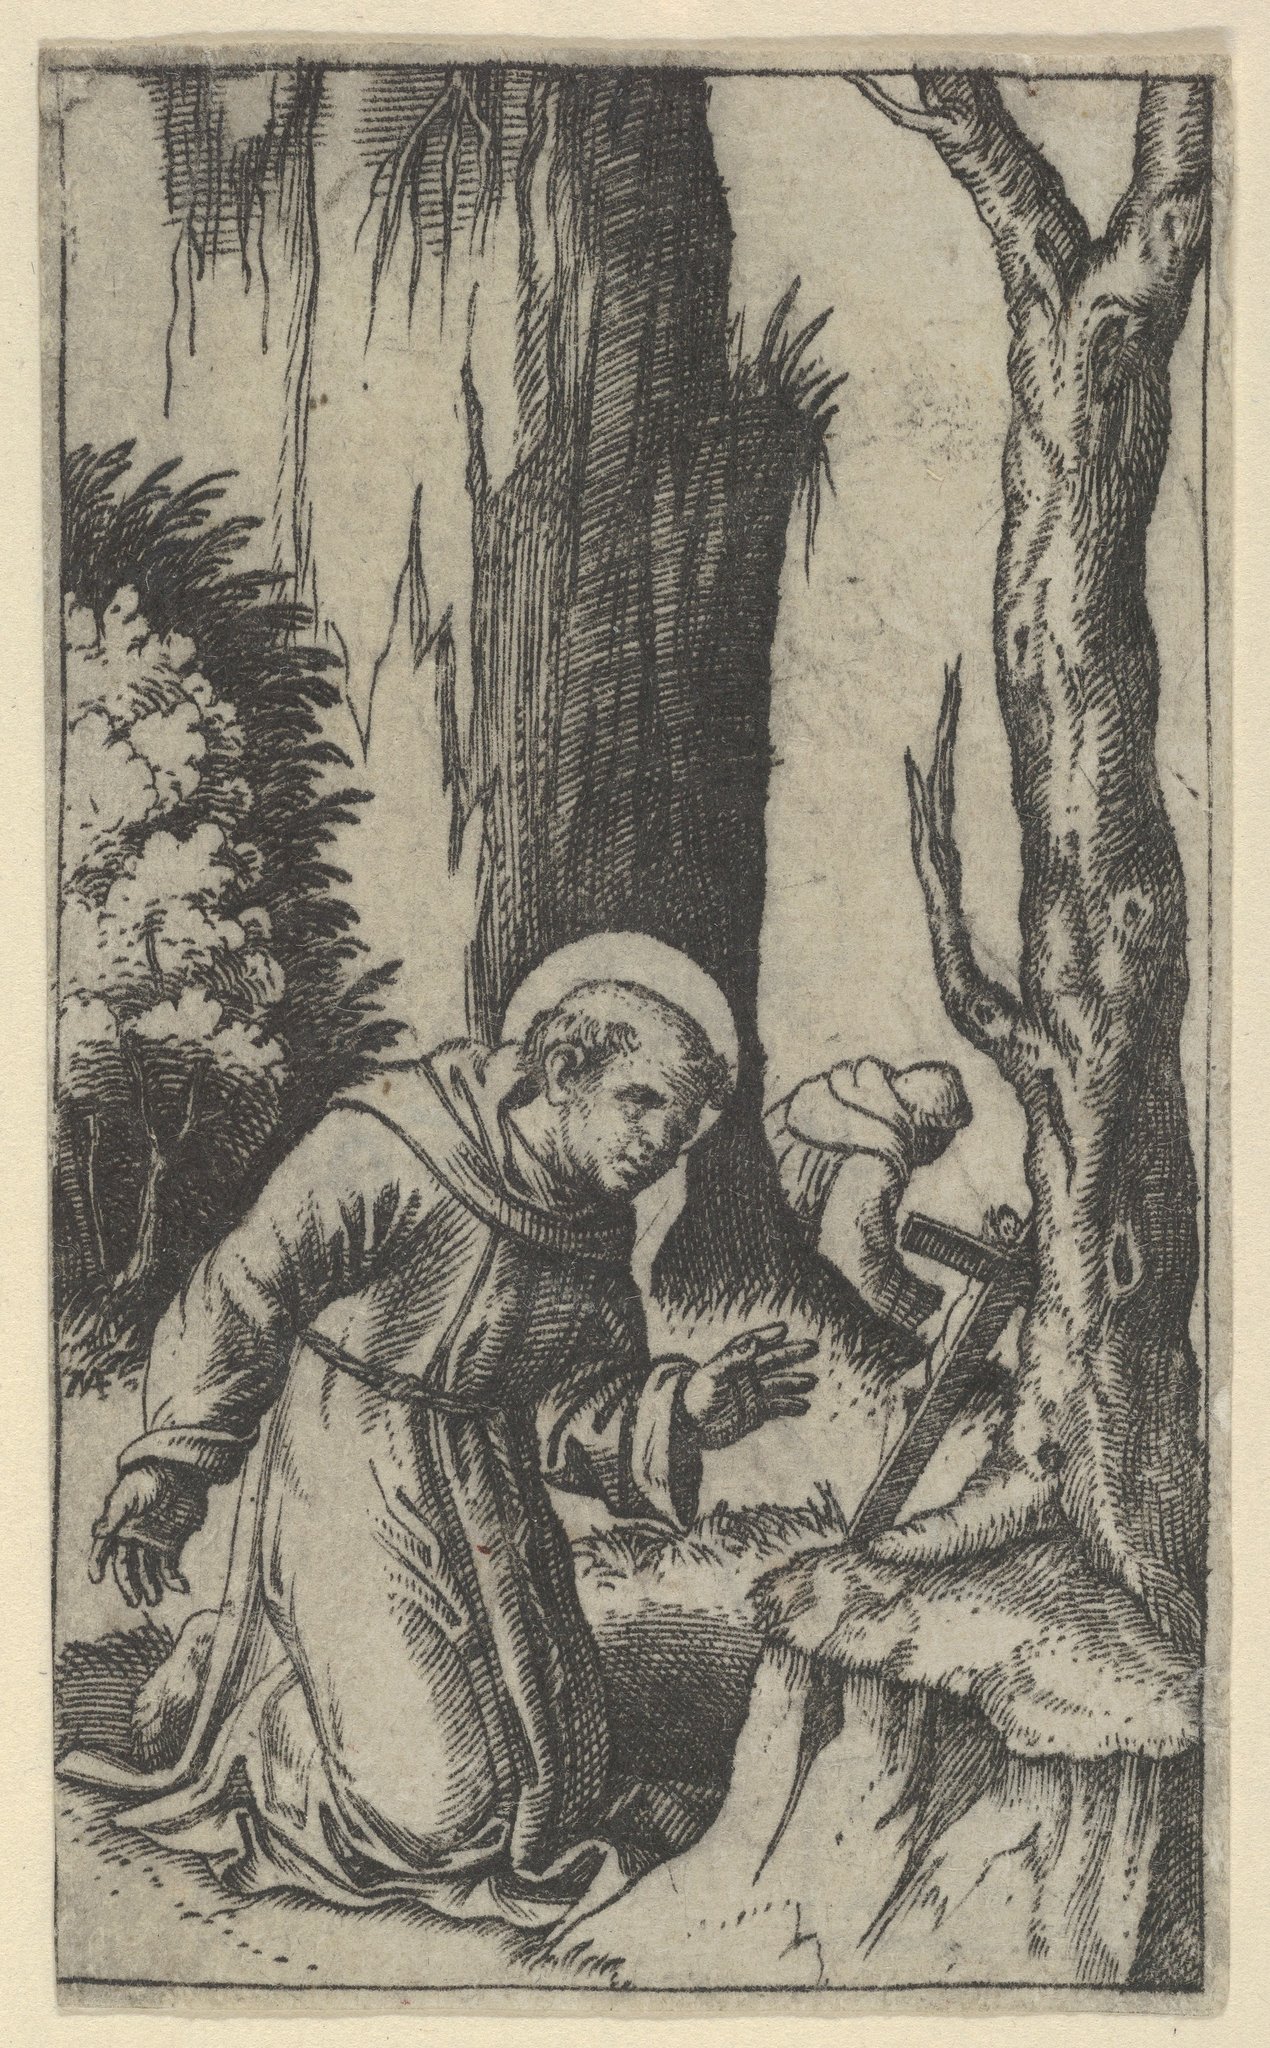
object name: print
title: Saint Francis of Assisi praying before a crucifix, from "Piccoli Santi" (Small Saints)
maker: marcantonio raimondi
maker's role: artist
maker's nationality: italian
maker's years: 1475-1534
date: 1500-1527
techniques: engraving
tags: trees,saint francis,cross